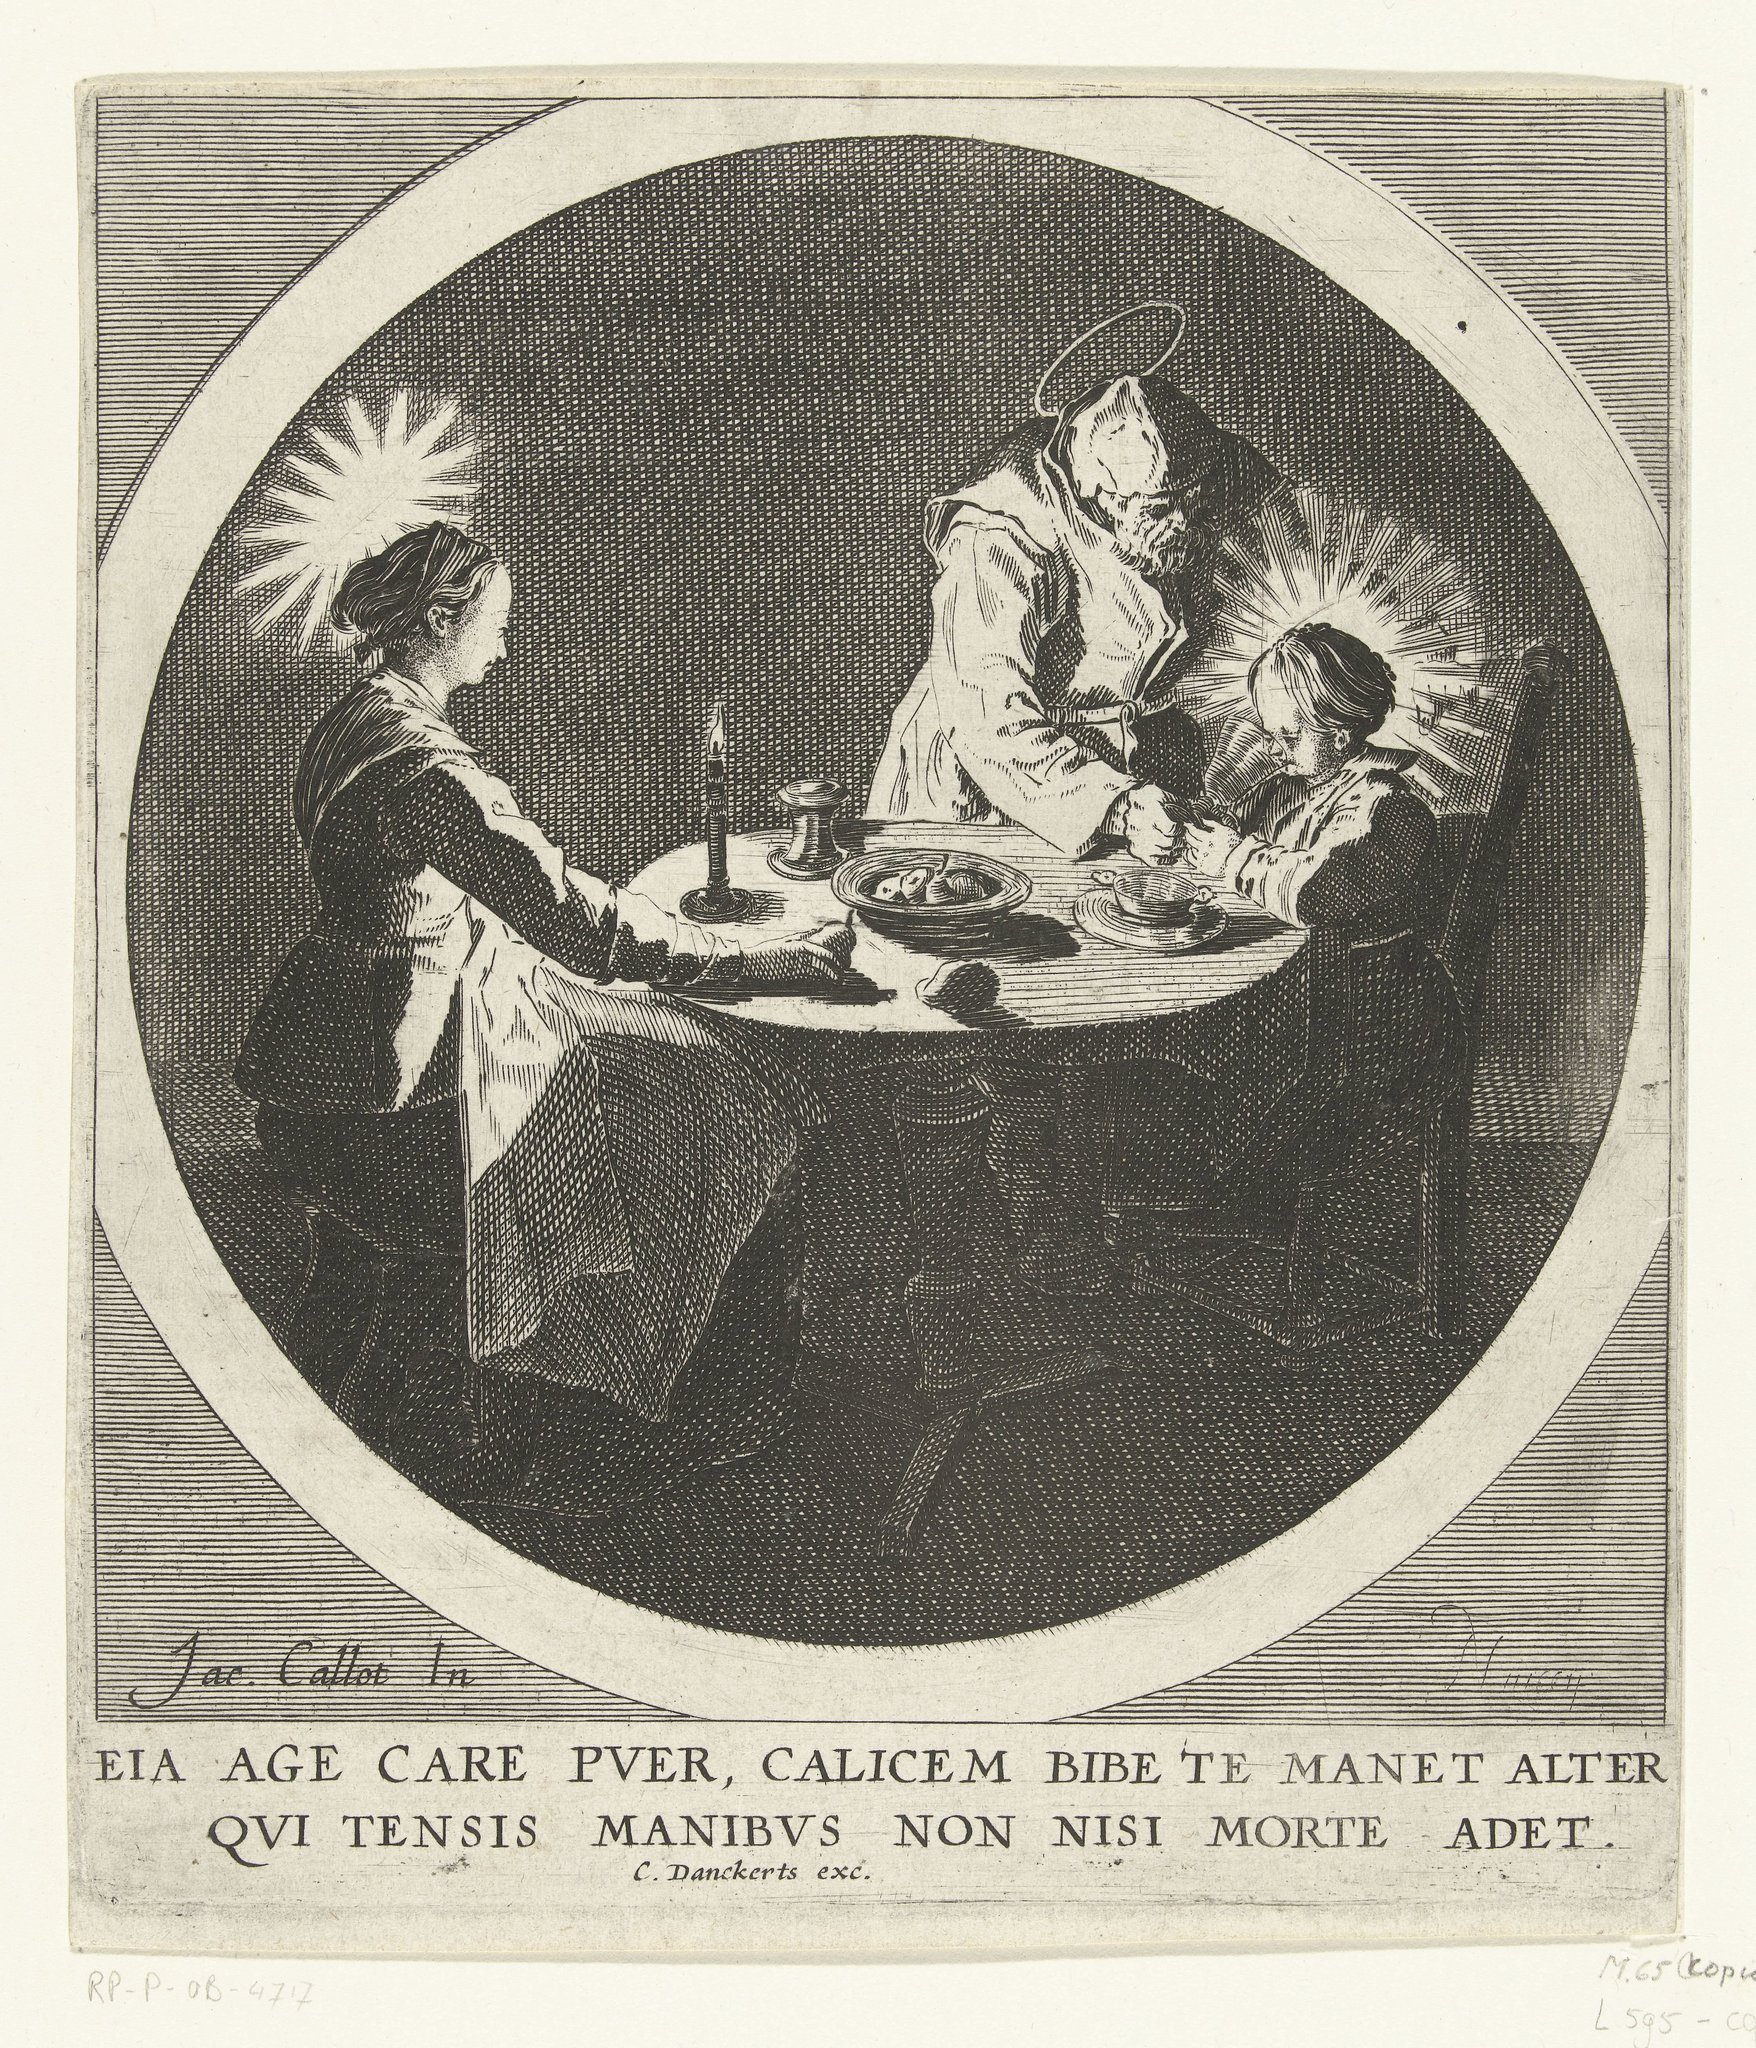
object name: print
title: De Heilige Familie aan tafel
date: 1628-1670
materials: paper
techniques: etching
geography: amsterdam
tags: holy family, and derived representations, (family) meal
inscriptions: collector's mark: Lugt 240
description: Aan een ronde tafel zit Maria (links) tegenover de kleine Christus (rechts), die door Jozef geholpen wordt bij het drinken uit een glas. Voorstelling is gevat in ronde omlijsting die zelf weer in vierkant kader is geplaatst. Eronder een tweeregelig onderschrift in Latijn.